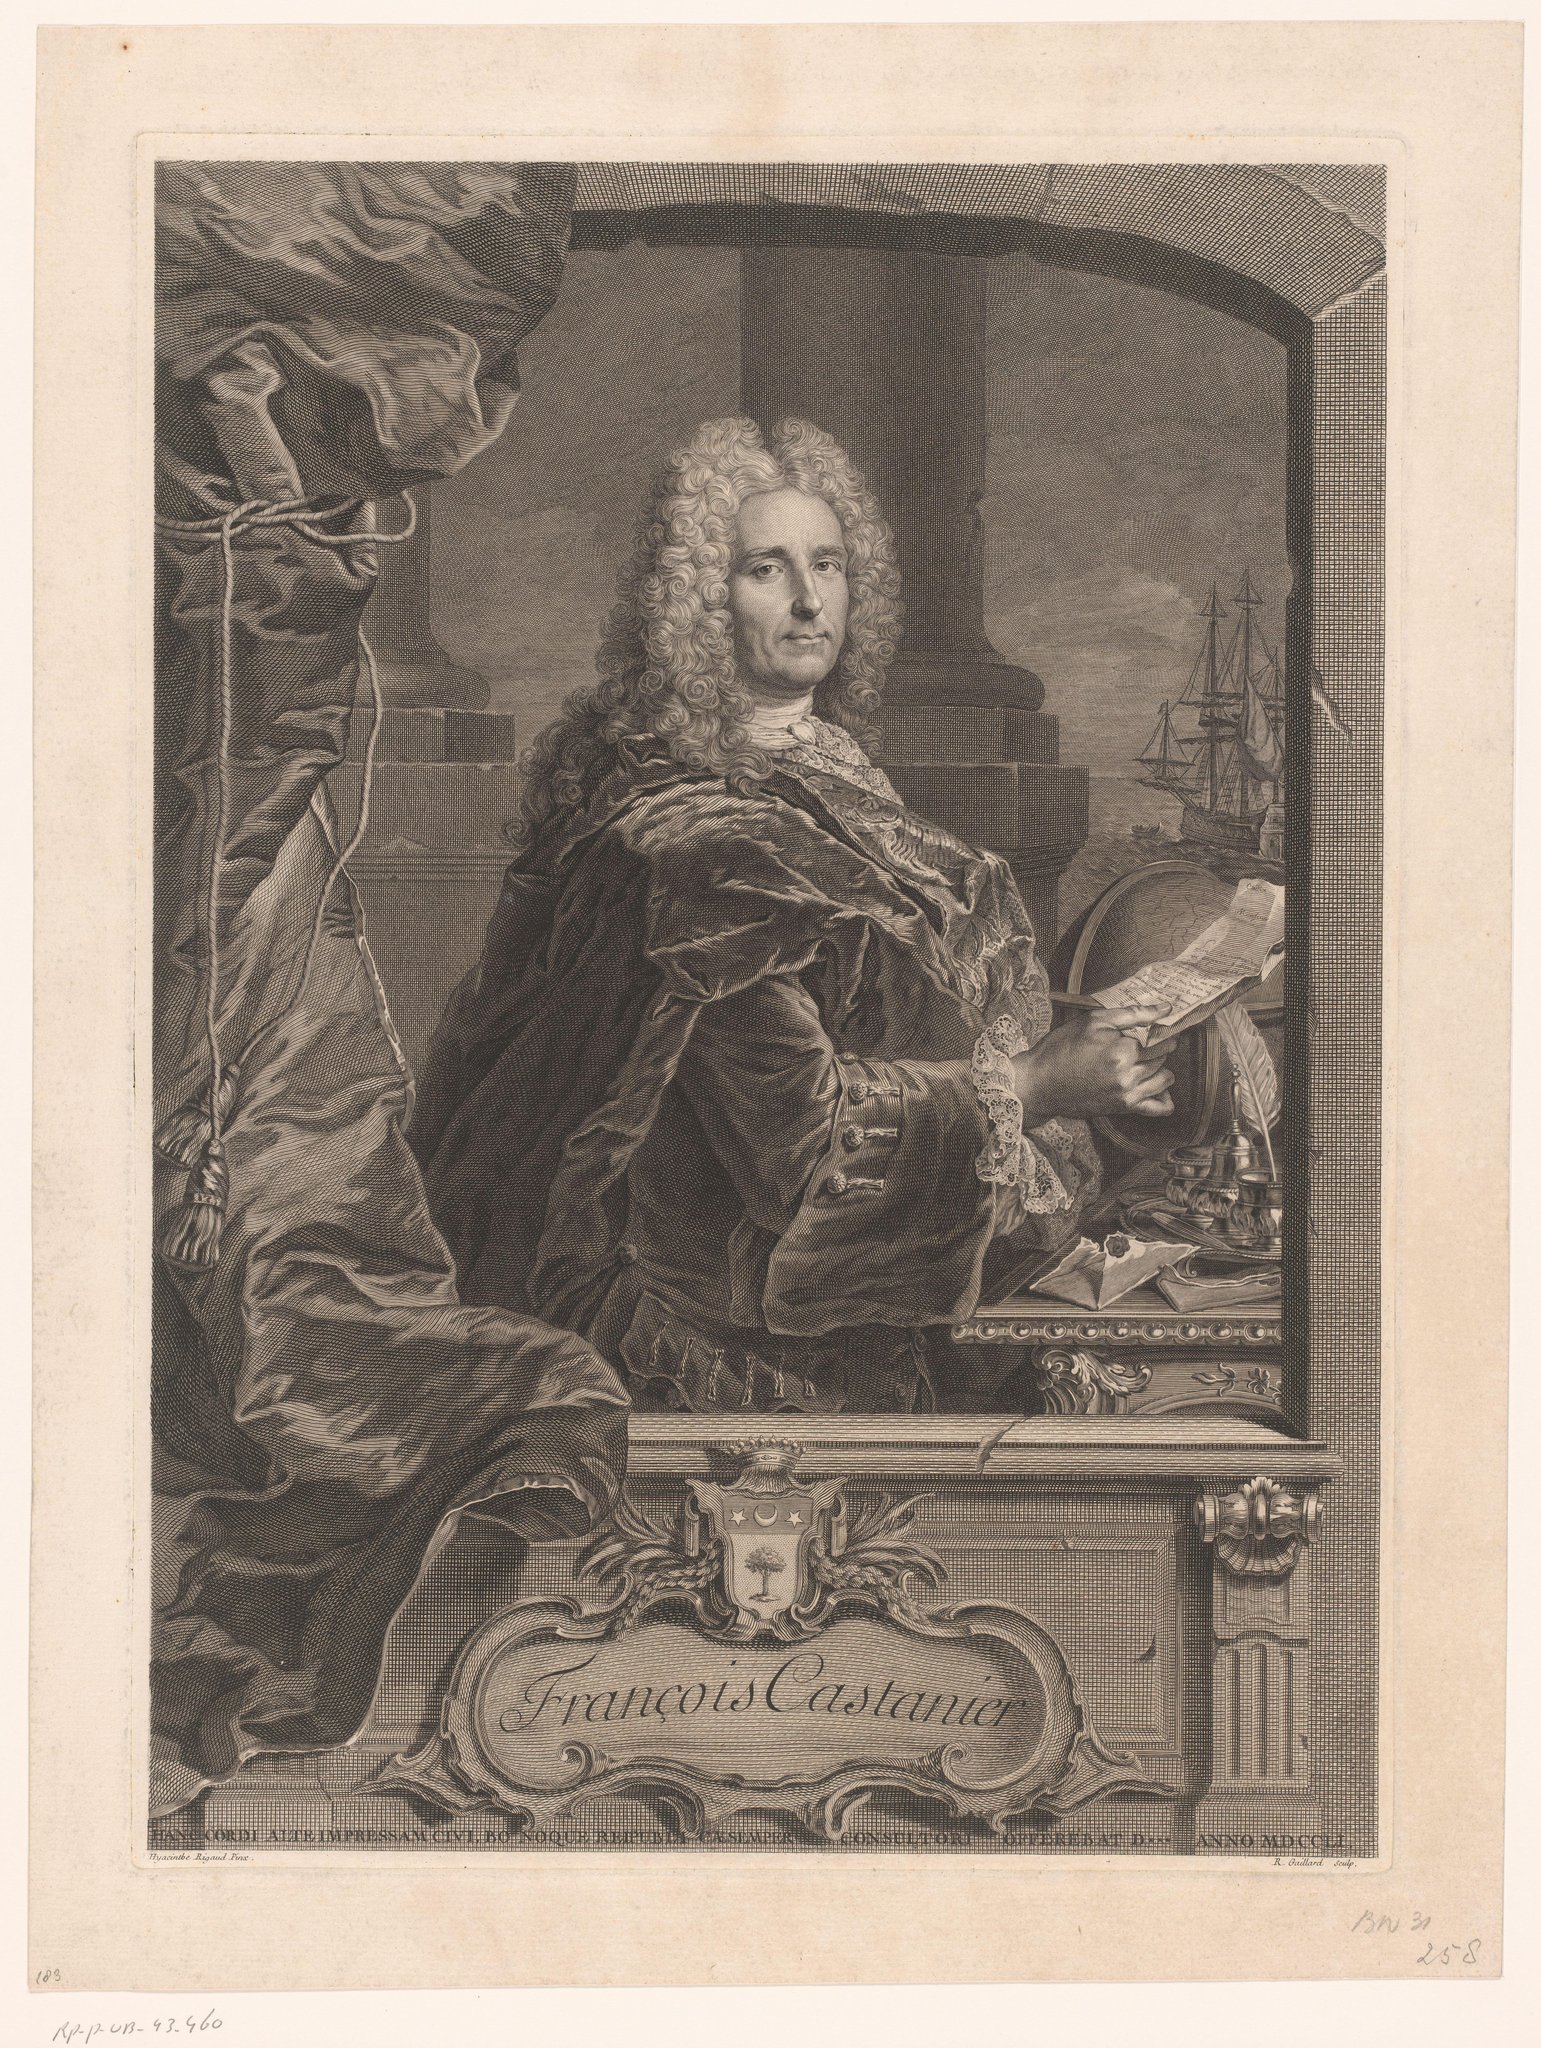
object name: print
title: Portret van François Castanier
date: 1751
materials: paper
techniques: engraving, etching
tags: historical persons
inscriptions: date